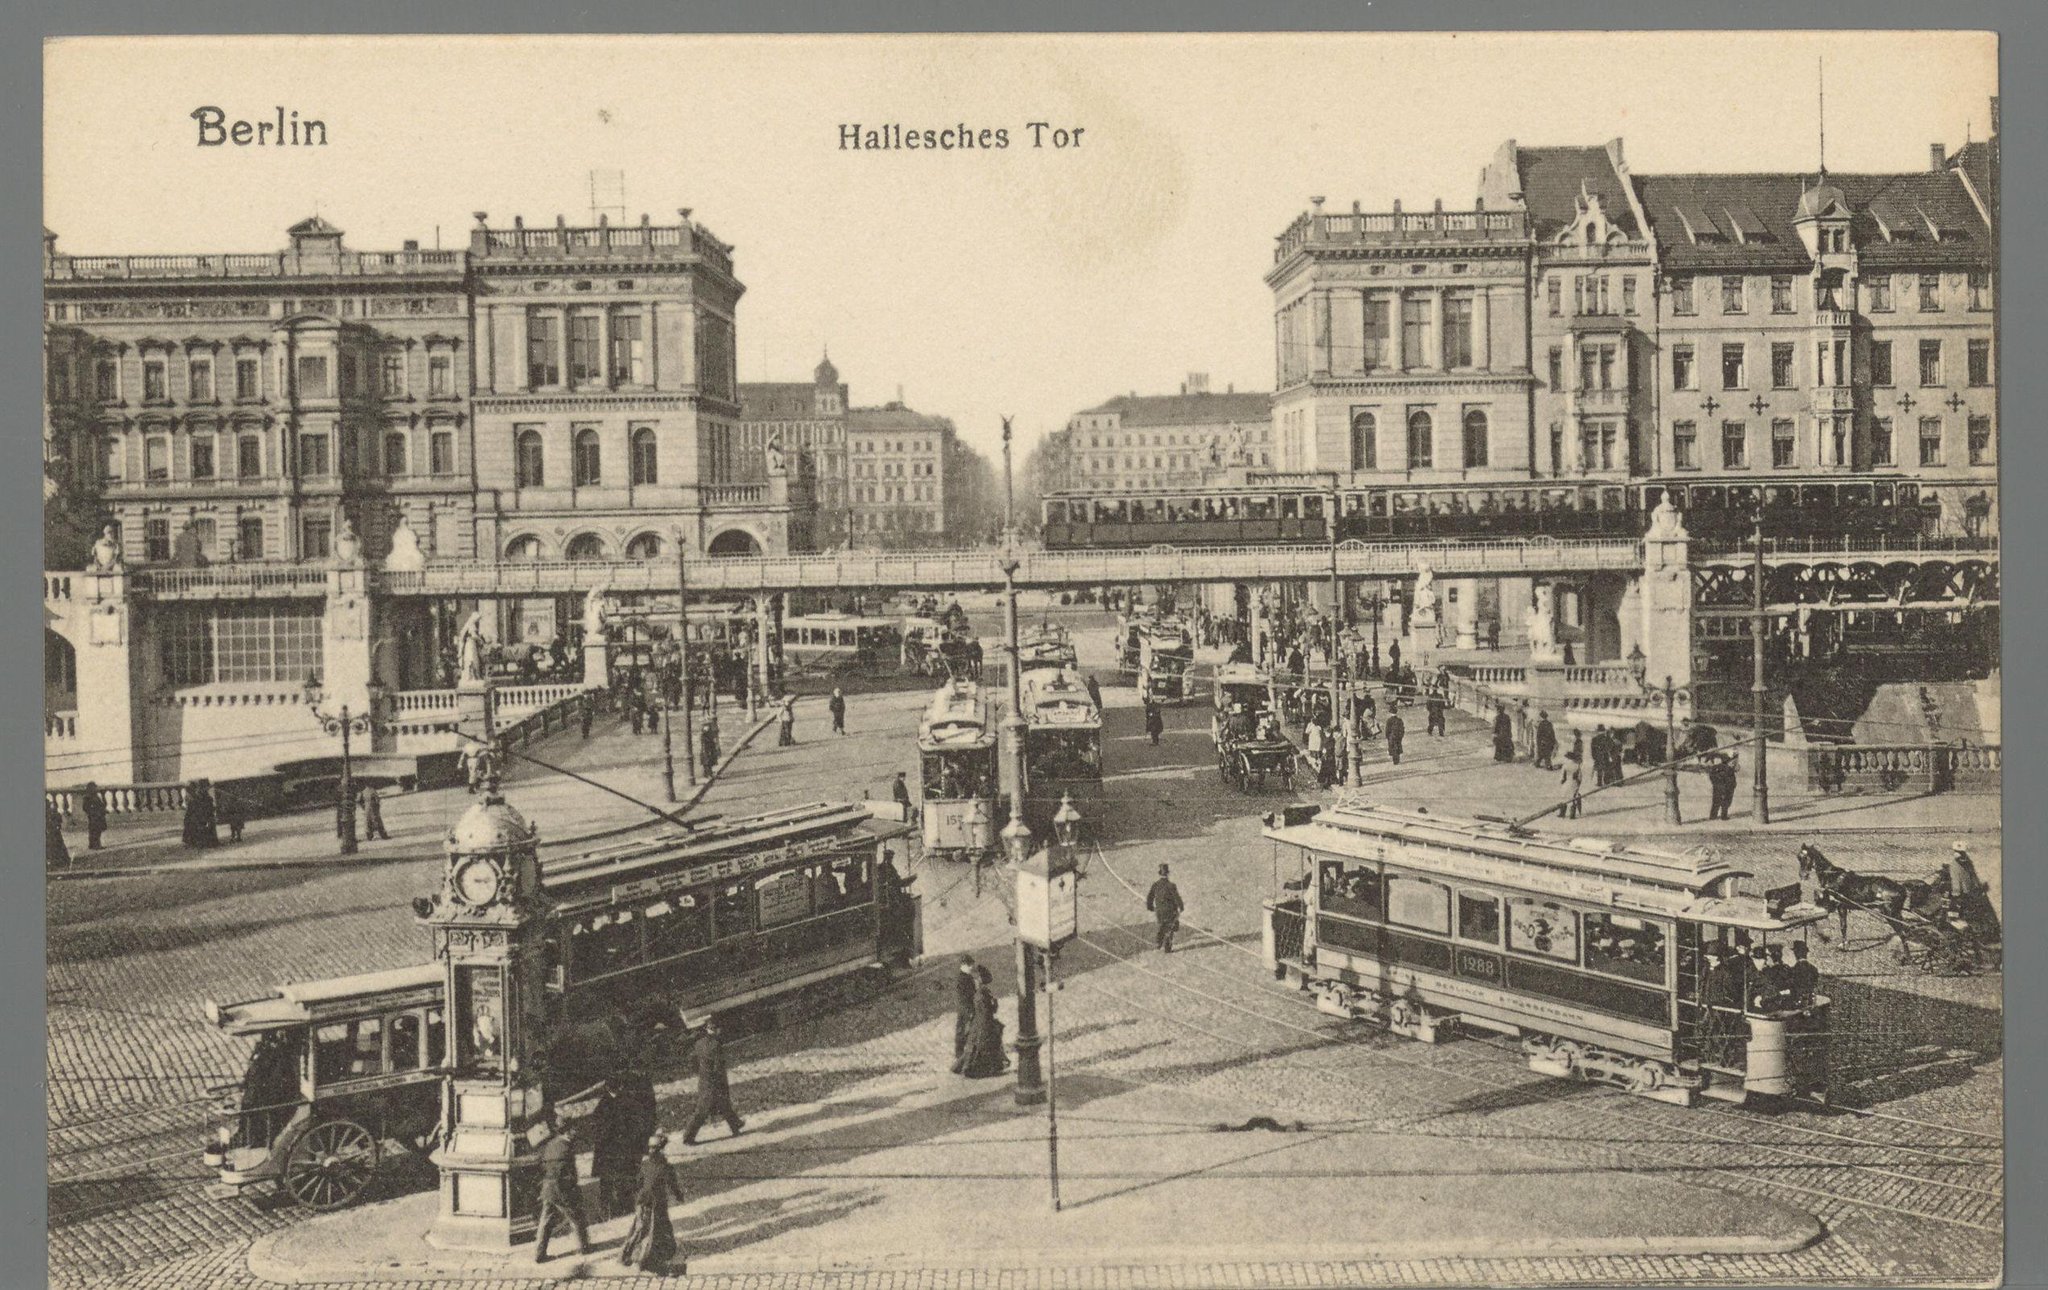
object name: photomechanical print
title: Berlin. Hallesches Tor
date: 1905-1930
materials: cardboard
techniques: photograph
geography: berlin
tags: railway, train, station; shelter (railway, tramway), street, berlin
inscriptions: stamp: ‘5’, monogram: ‘P.F.B.’